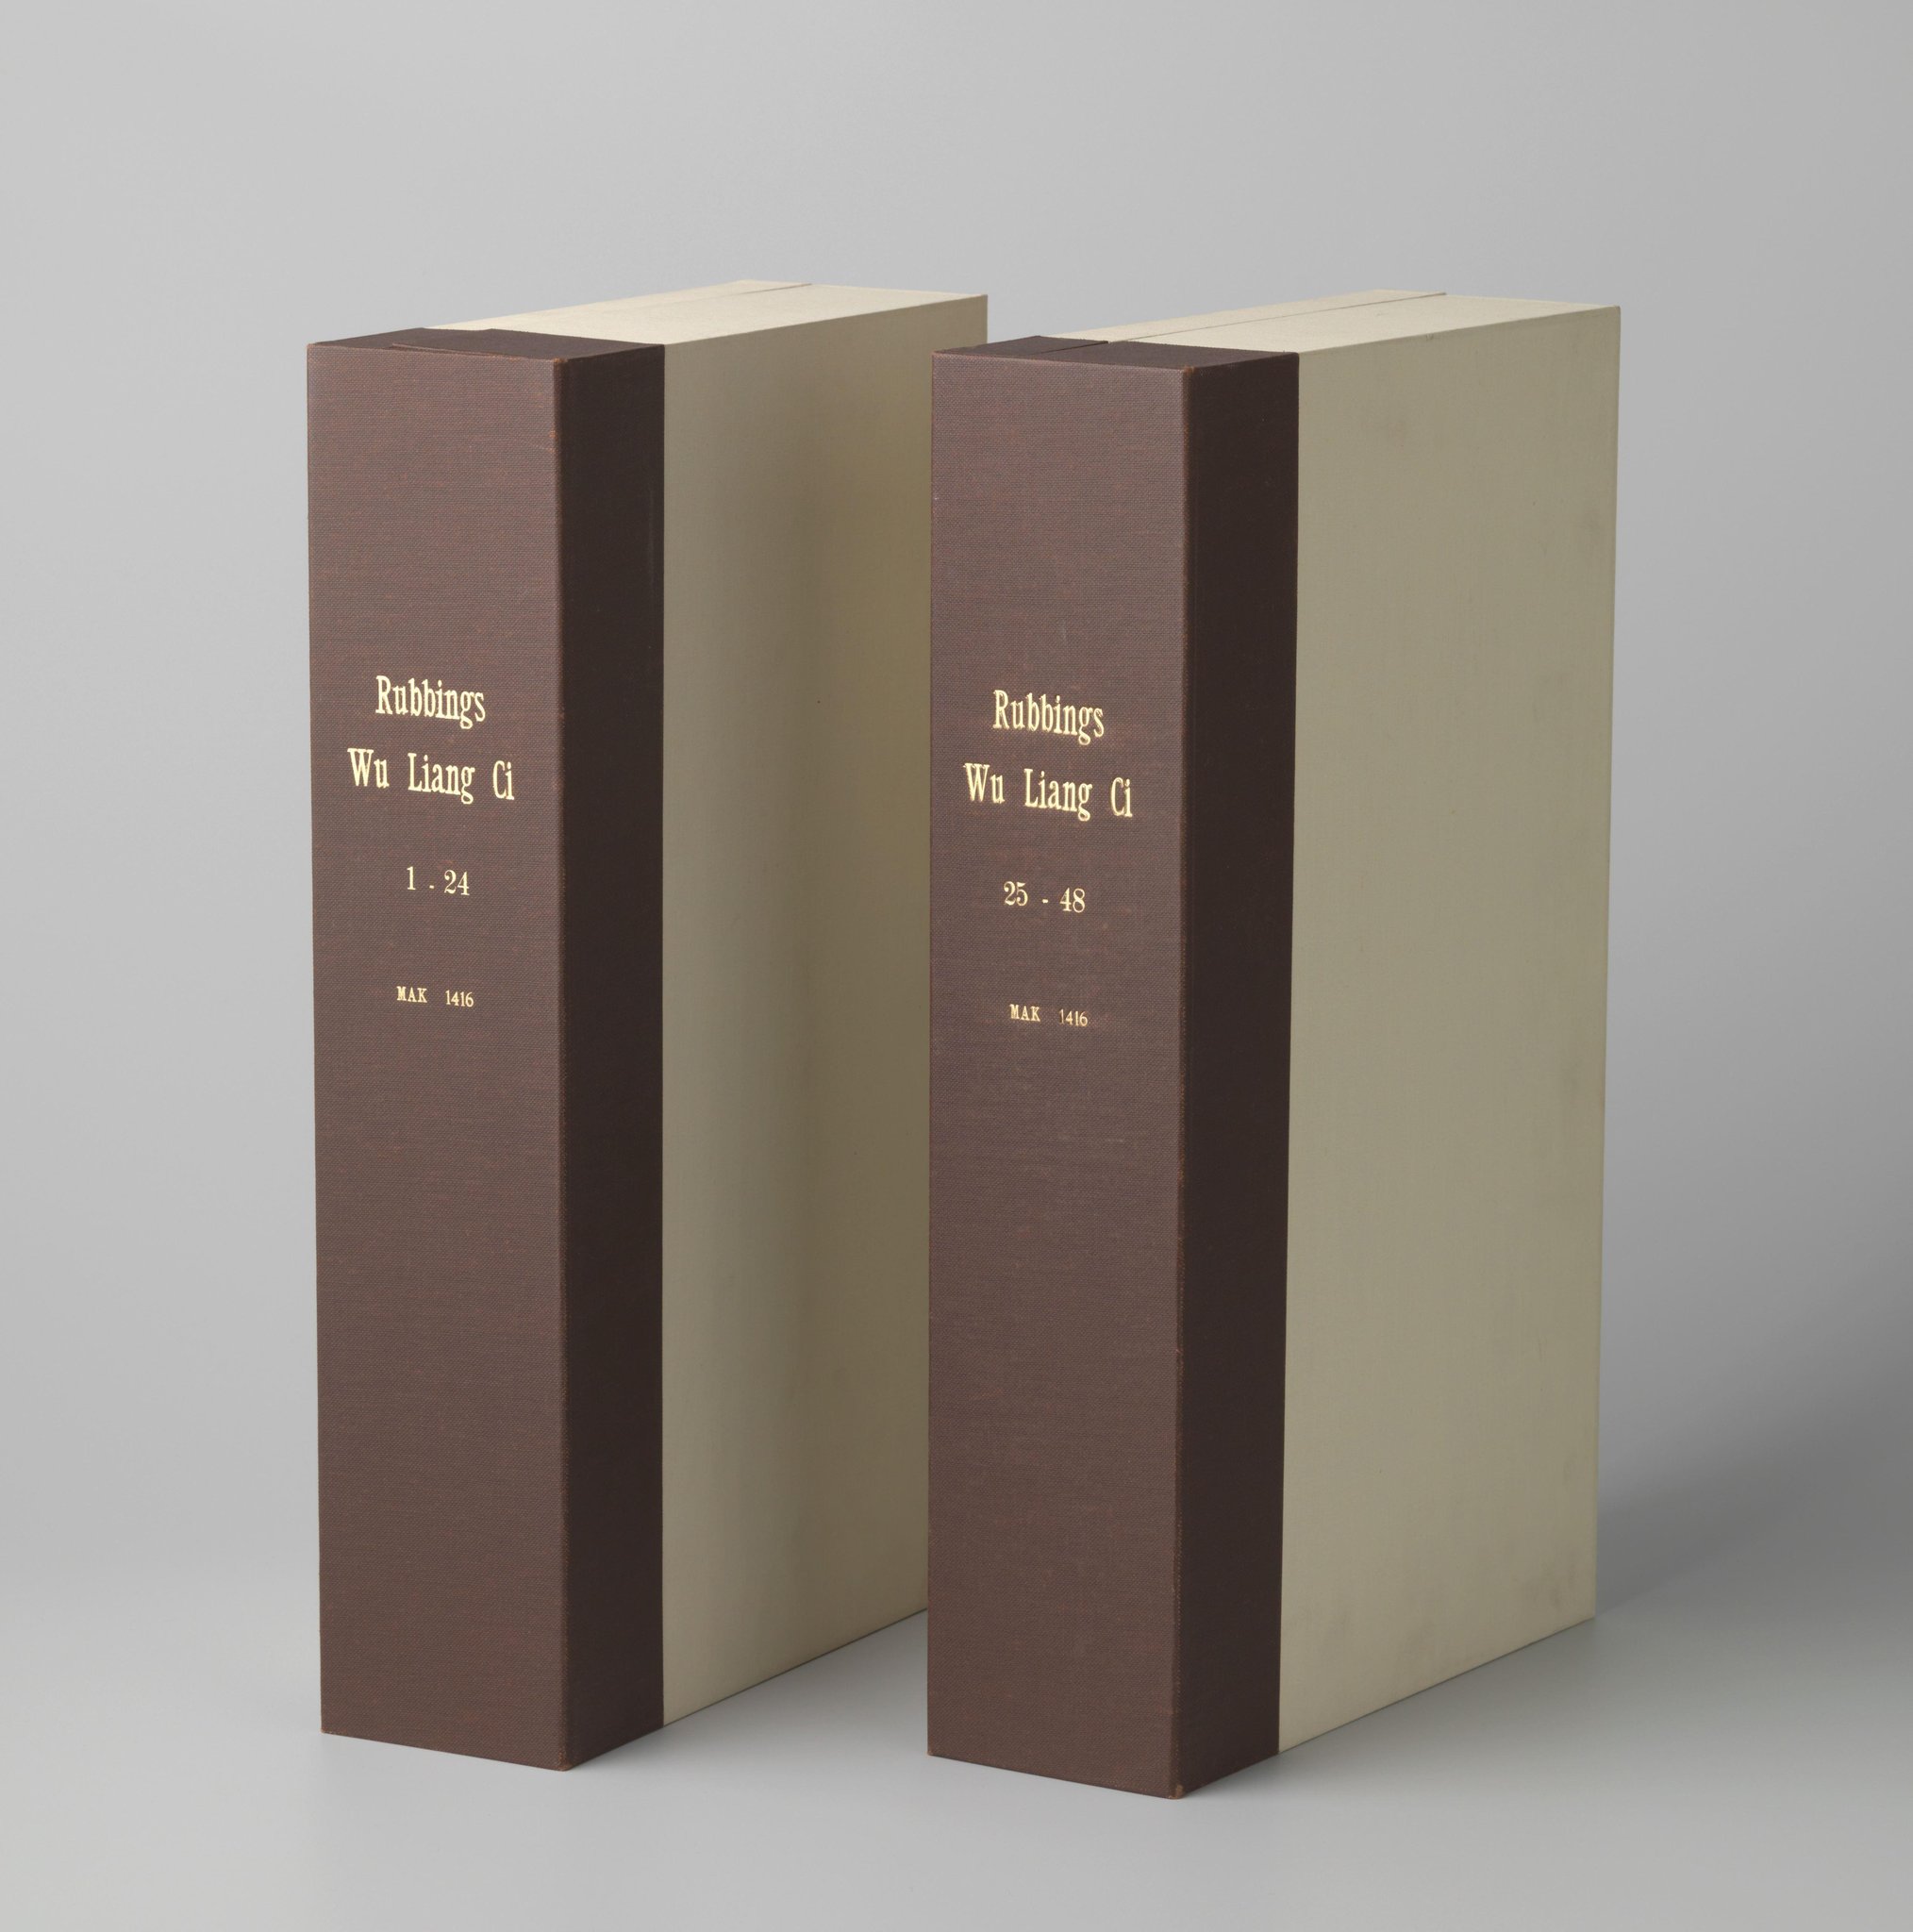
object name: wrijfprent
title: Album met wrijfprenten, nummers AK-MAK-1416-Z, AK-MAK-1416-AA t/m -WW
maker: Anonymous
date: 150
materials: ink, paper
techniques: rubbing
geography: shandong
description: Rubbings van steenreliëf, de thema's zijn ontleend aan de geschiedenis, mythologie en religie van het voorboeddhistische China.